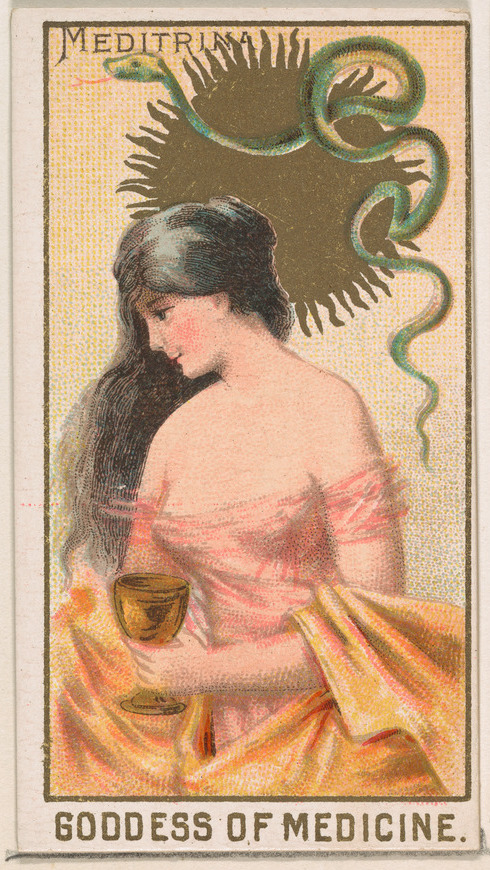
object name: print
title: Meditrina, Goddess of Medicine, from the Goddesses of the Greeks and Romans series (N188) issued by Wm. S. Kimball & Co.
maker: william s. kimball & company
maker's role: publisher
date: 1889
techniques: color lithograph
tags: serpents,goddess